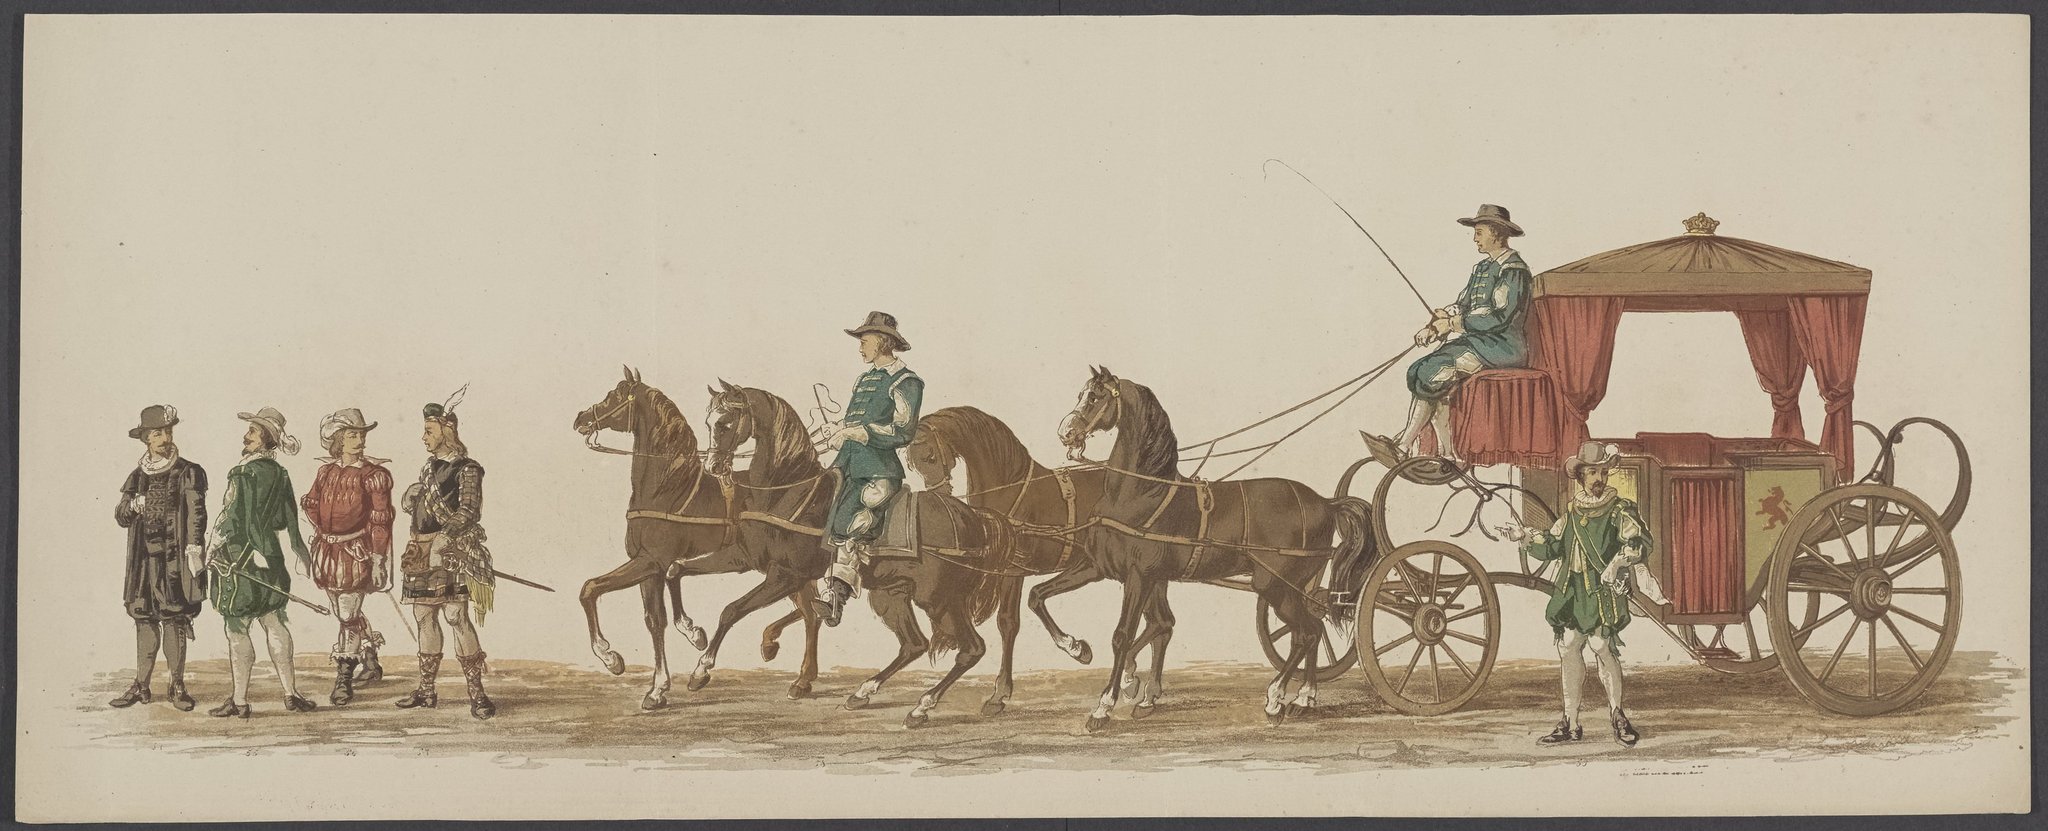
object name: print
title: Vierde Lustrum der Koninklijke Academie te Delft - Ao. 1862 - Gekostumeerde Optogt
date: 1862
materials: paper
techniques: chromolithography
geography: rotterdam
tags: university, students' pageant, costumes used in pageants, commemoration of the founding of a university, delft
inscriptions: collector's mark: Lugt 2228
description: Vierde en vijfde groep: buitenlandse gezanten te voet en de staatsiekoets van prins Maurits, genummerd 54-59. Onderdeel van de serie van acht platen van de gekostumeerde optocht gehouden door de studenten van de Koninklijke Academie te Delft bij het vierde lustrum op 8 juni 1862, plus intekenlijst en ledenlijst. De stoet stelt voor het gezantschap van de sultan van Atjeh aan prins Maurits en de Staten op 4 september 1602.